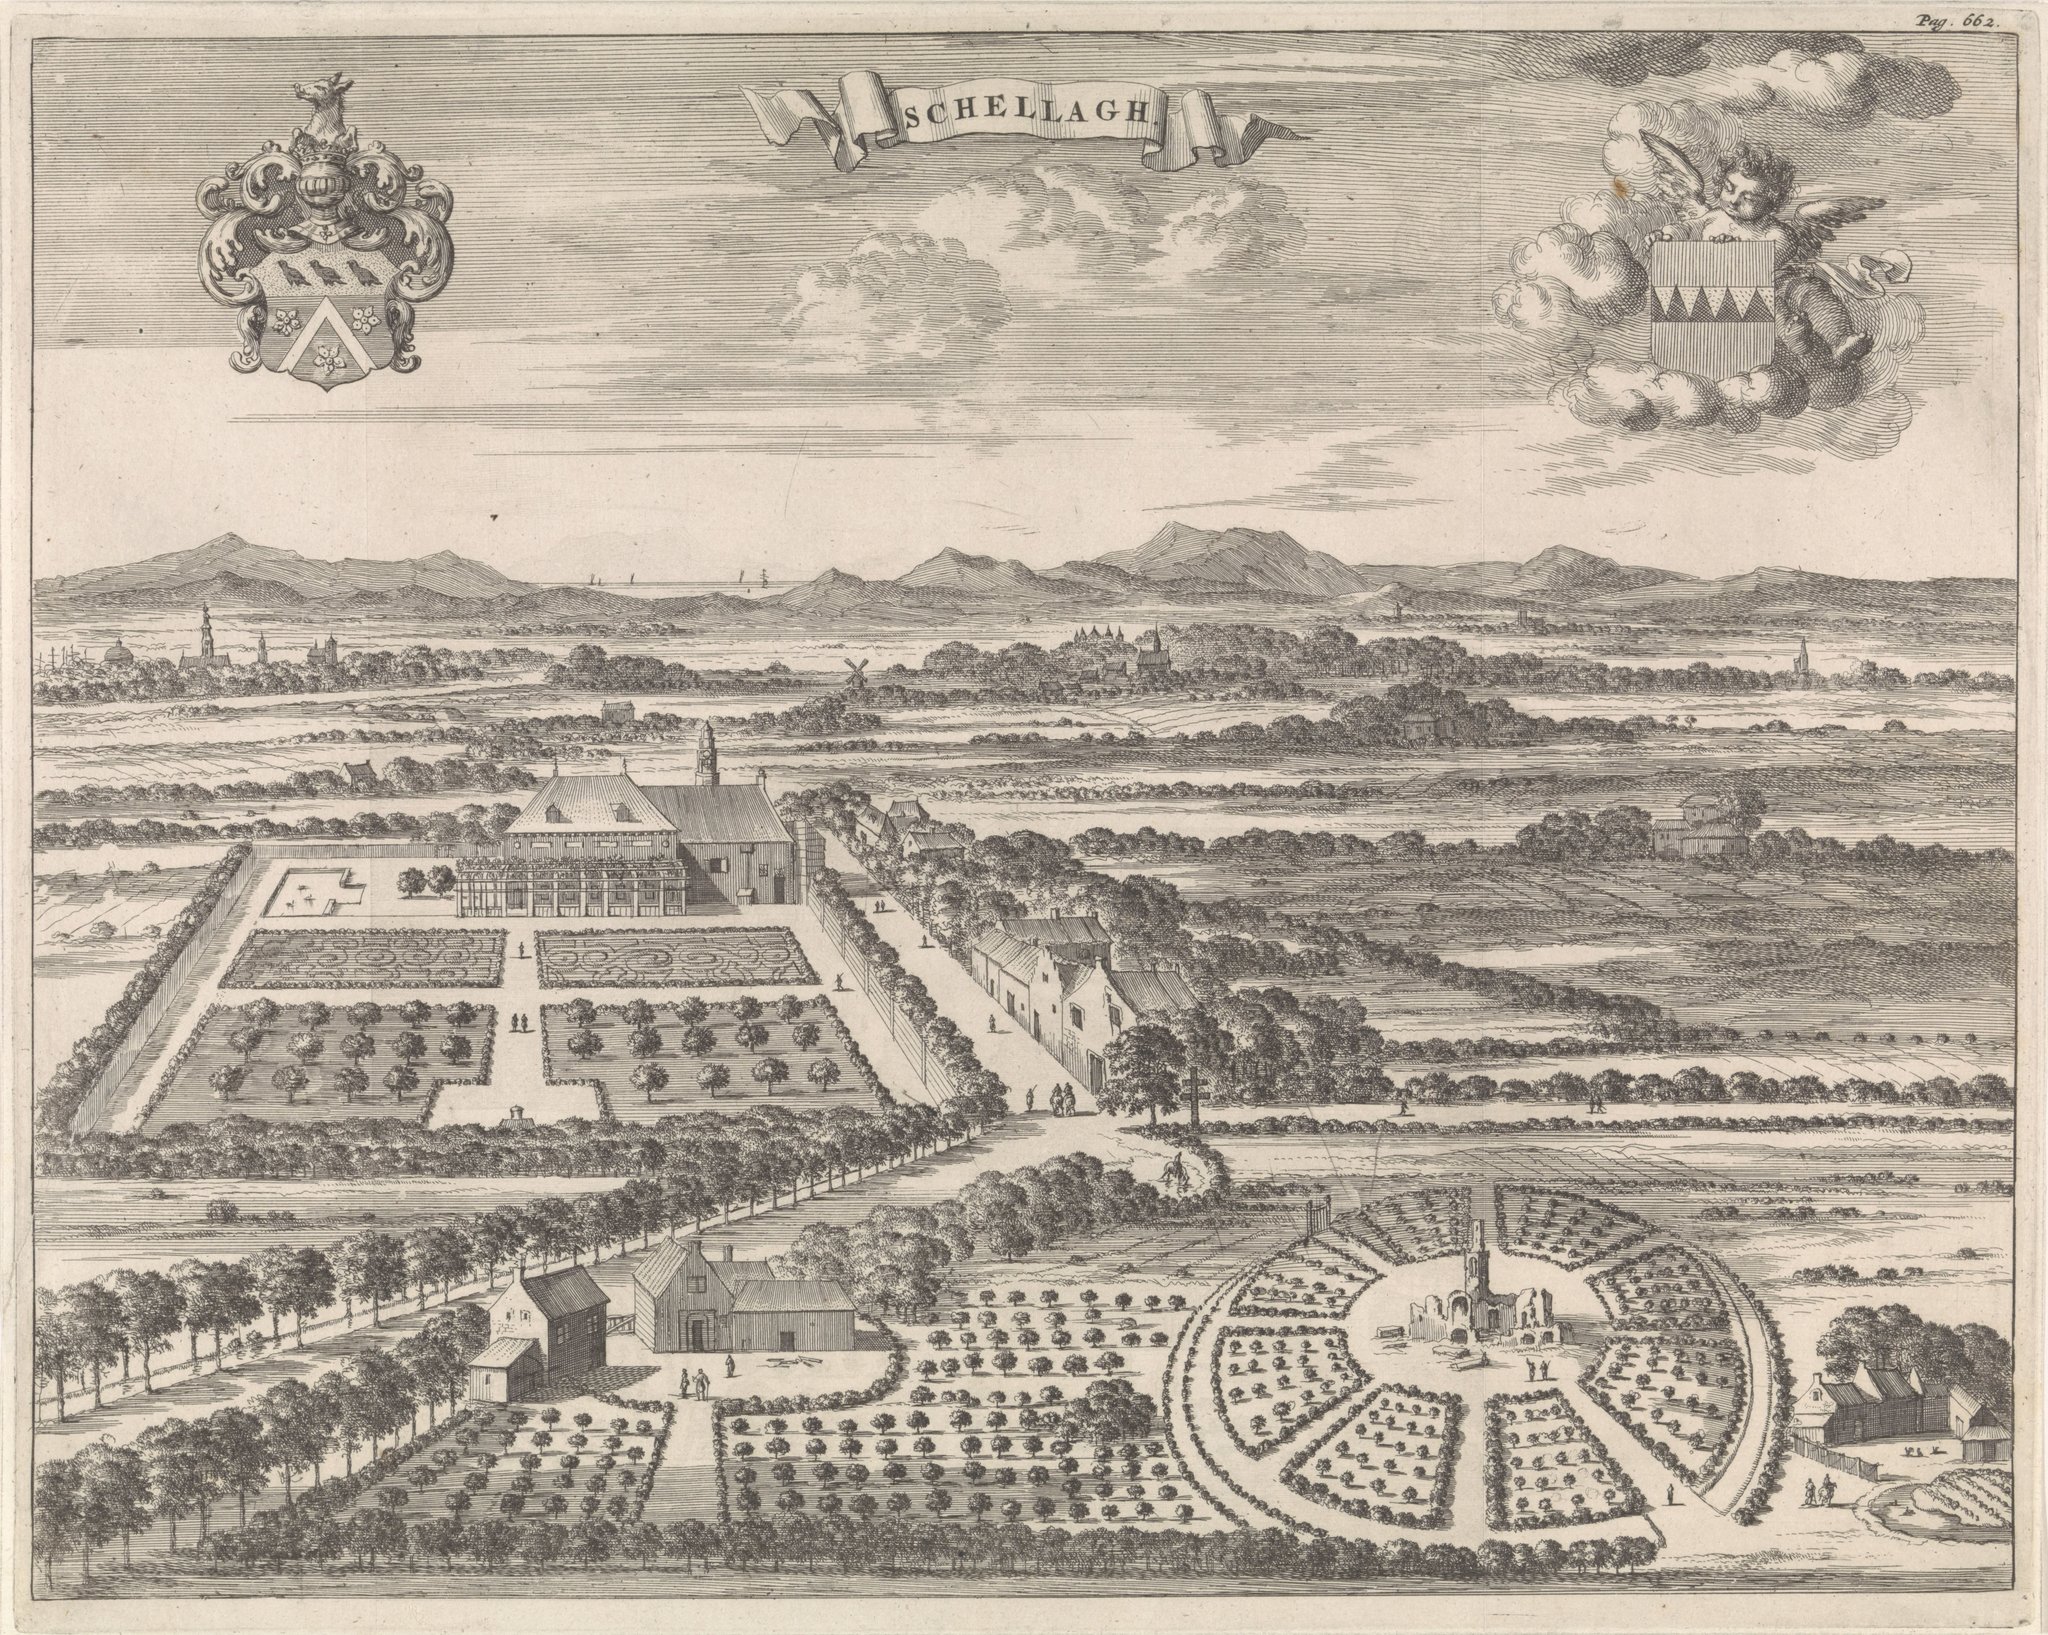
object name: print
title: Schellagh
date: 1696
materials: paper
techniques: engraving, etching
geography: amsterdam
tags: prospect of village, silhouette of village, coat of arms (as symbol of the state, etc.), ruins (garden ornaments), garden, french or architectonic garden; formal garden, armorial bearing, heraldry, country-house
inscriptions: collector's mark: Lugt 2228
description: Gezicht op de heerlijkheid Schellach, gelegen tussen Middelburg en Veere, in vogelvluchtperspectief. Linksboven het wapen van de familie Boudaen Courten, die de heerlijkheid in haar bezit had sinds Hendrik Boudaen Courten het had gekocht. Boven in het midden een banderol met de titel. Rechtsboven een putto met het wapen van Brigdamme. Rechts op de voorgrond een ruïne als middelpunt van de aangelegen tuin van de hofstede. Rechtsboven gemerkt: Pag. 662.